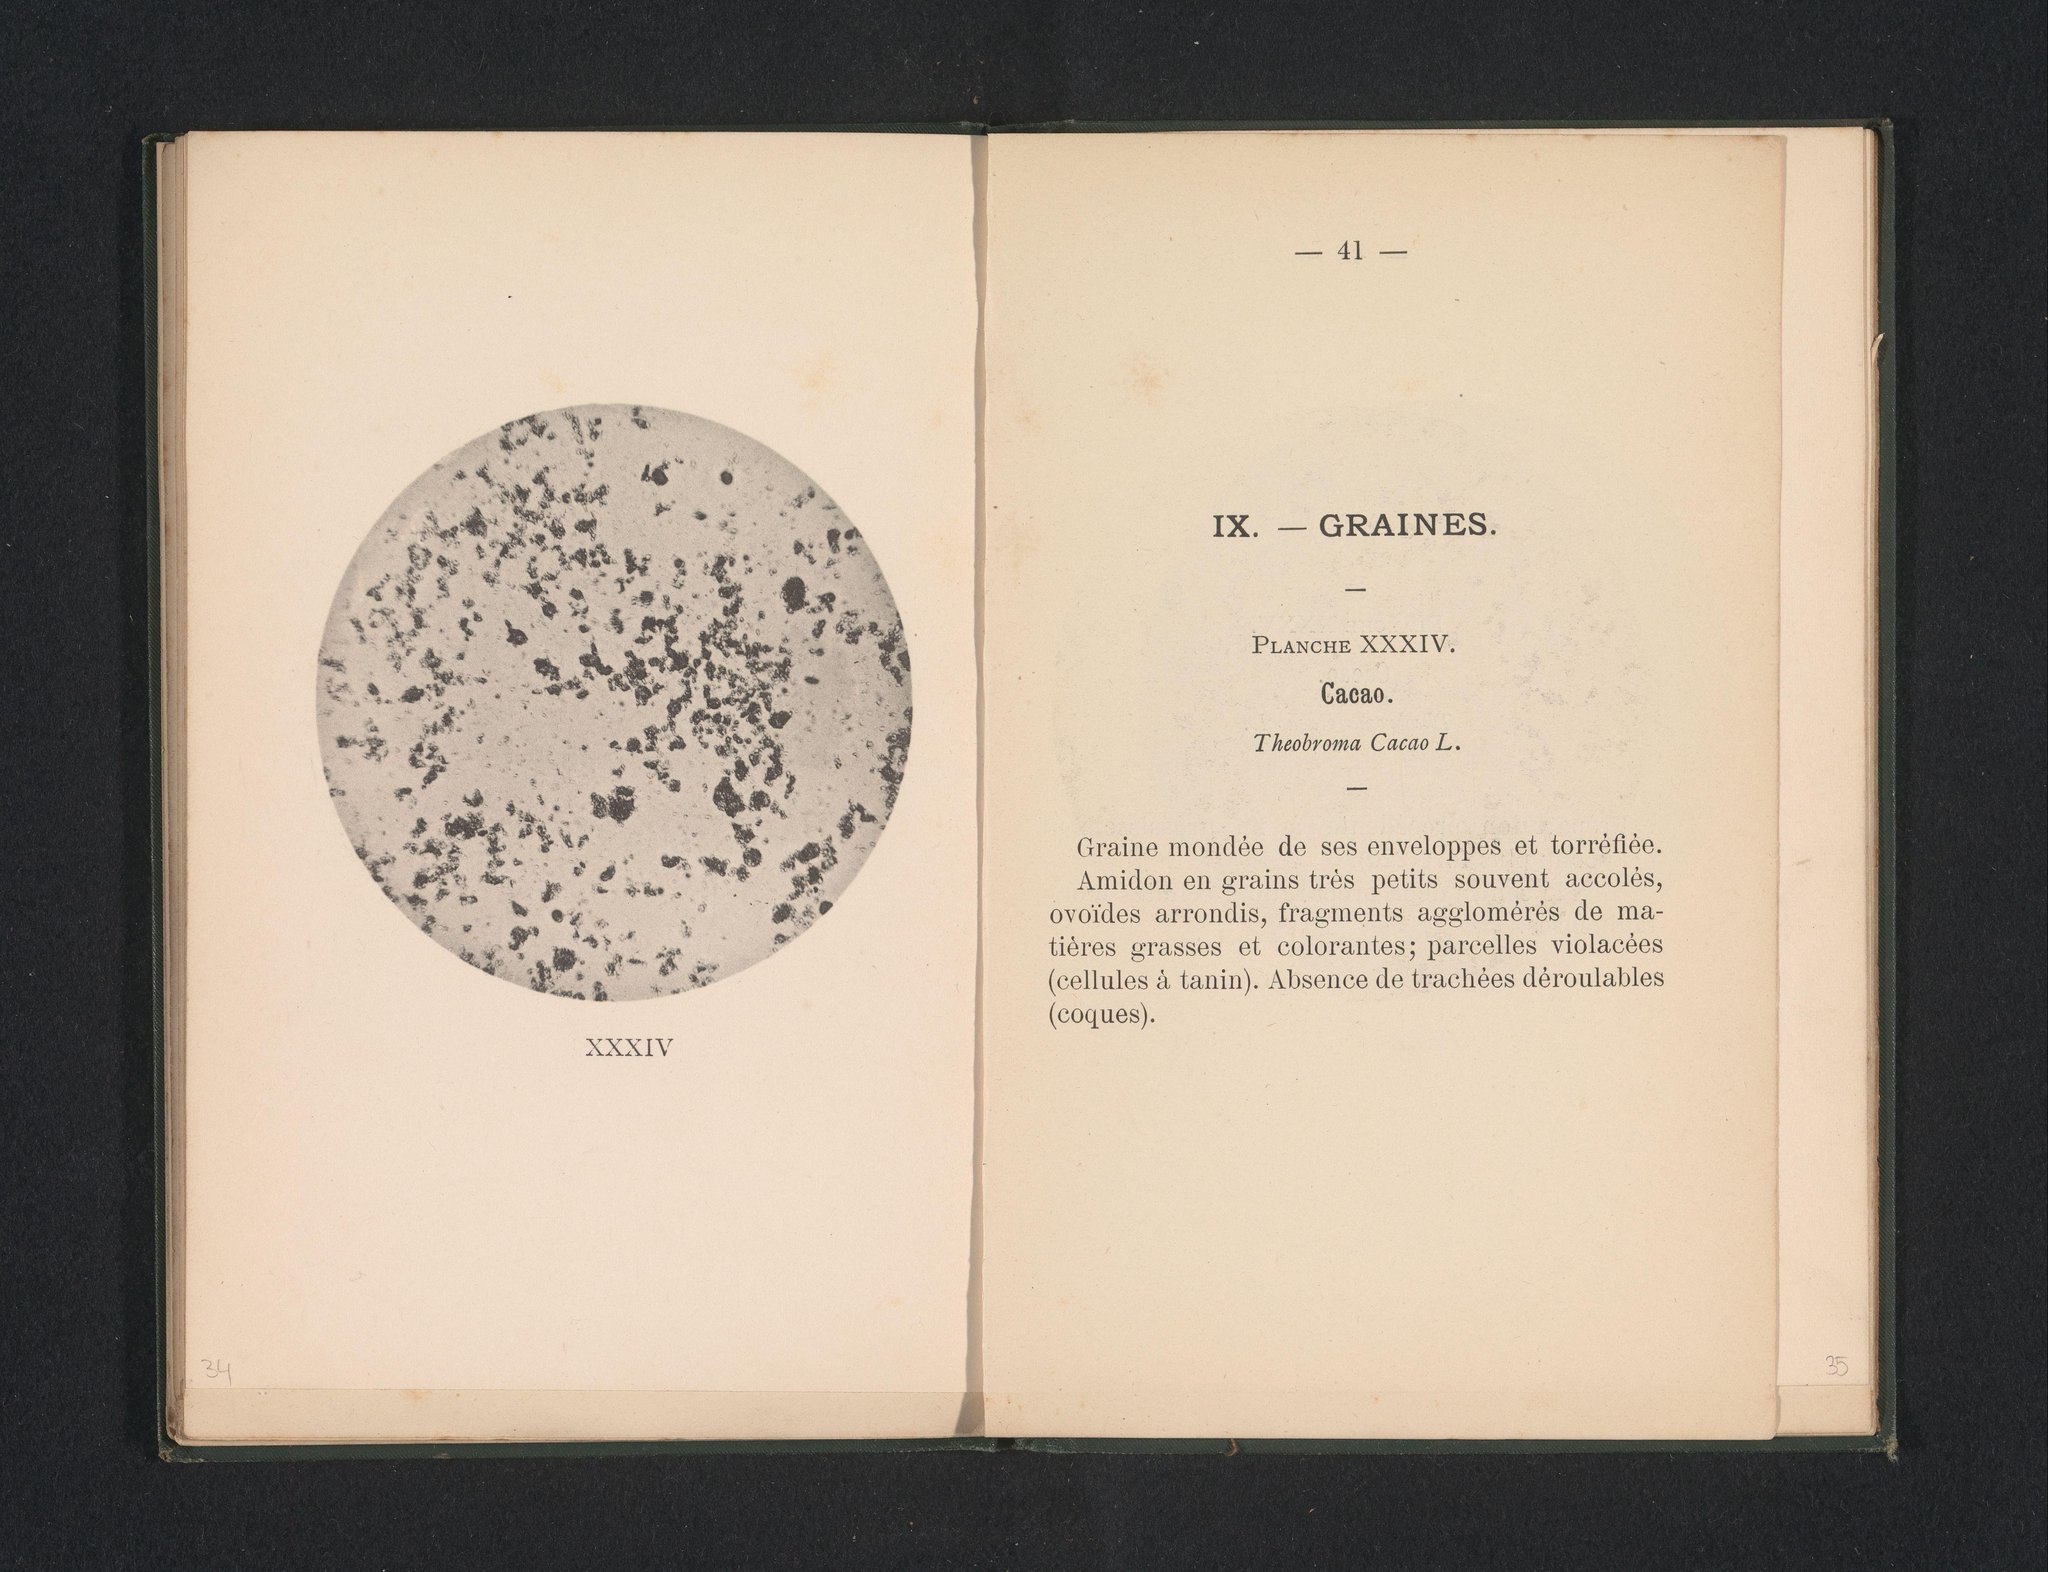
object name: photomechanical print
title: Microscopische weergave van cacao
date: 1891-1896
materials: paper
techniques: photograph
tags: microscope (+ scientific research)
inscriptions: number: ‘XXXIV’